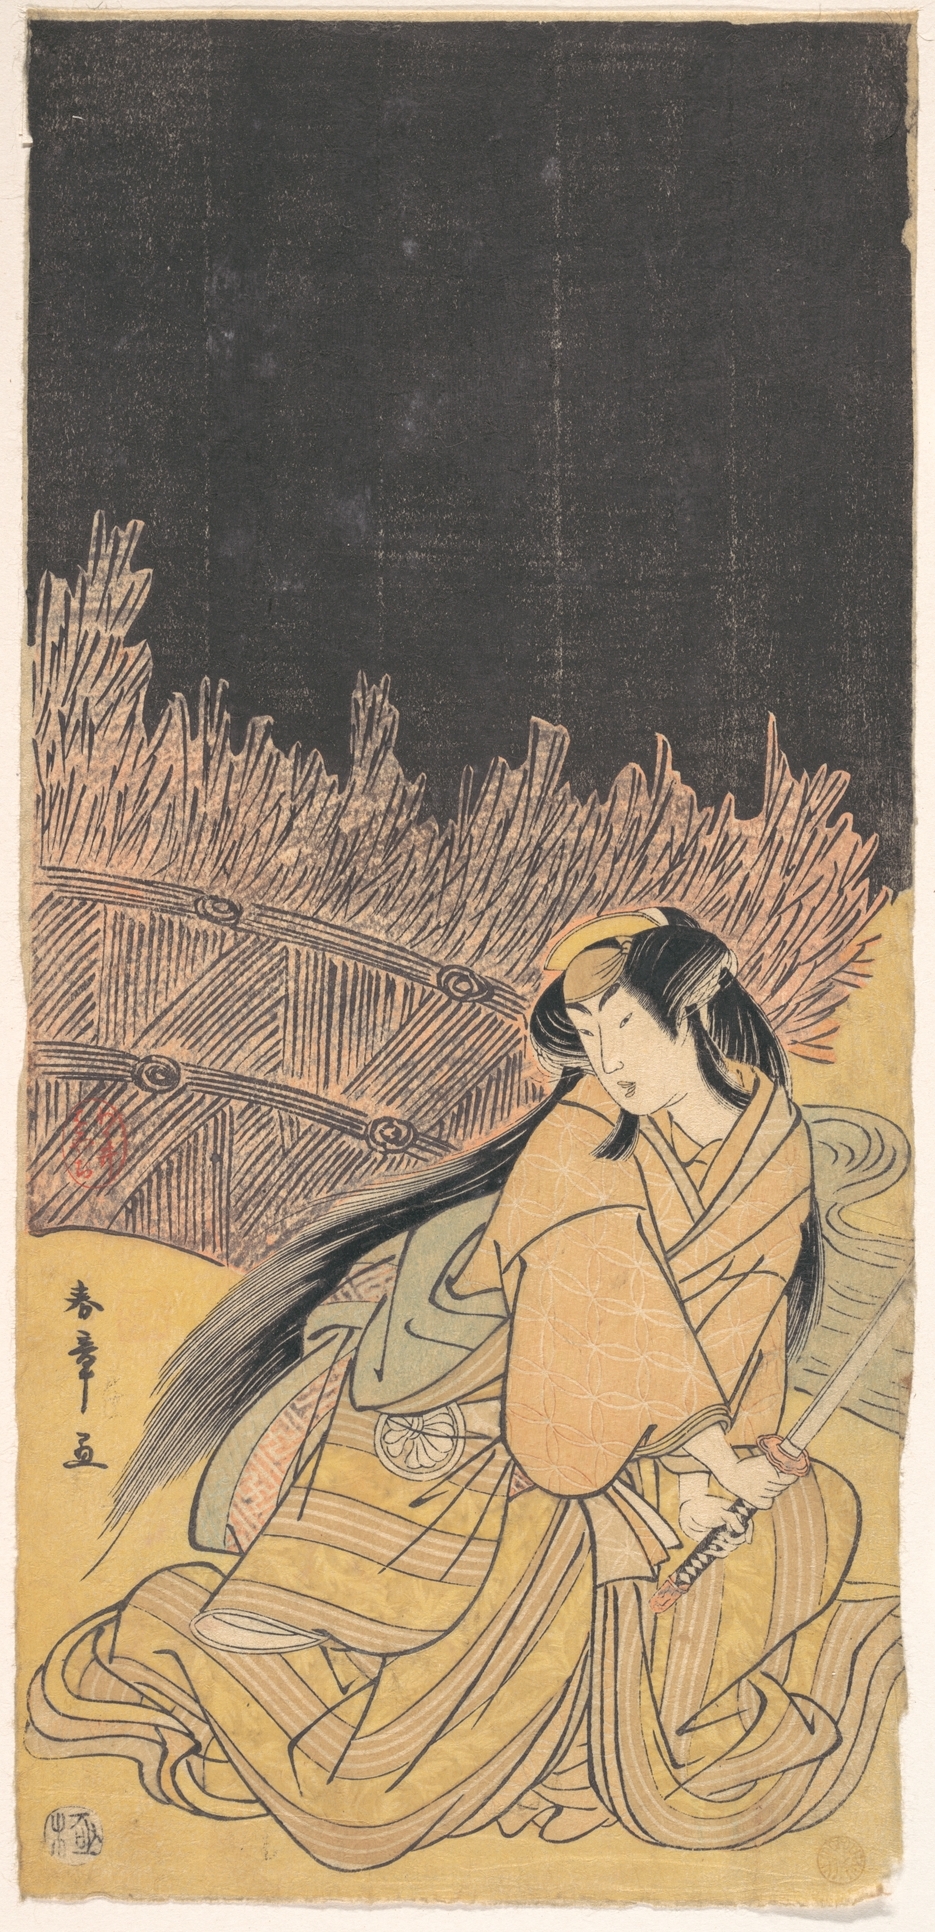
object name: woodblock print nishiki e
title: The Third Segawa Kikunojo as a Woman in a Crouching Position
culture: japanese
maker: katsukawa shunshō 勝川春章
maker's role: artist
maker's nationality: japanese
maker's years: 1726-1792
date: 1778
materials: ink, paper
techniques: nishiki e, woodblock print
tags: swords,actors